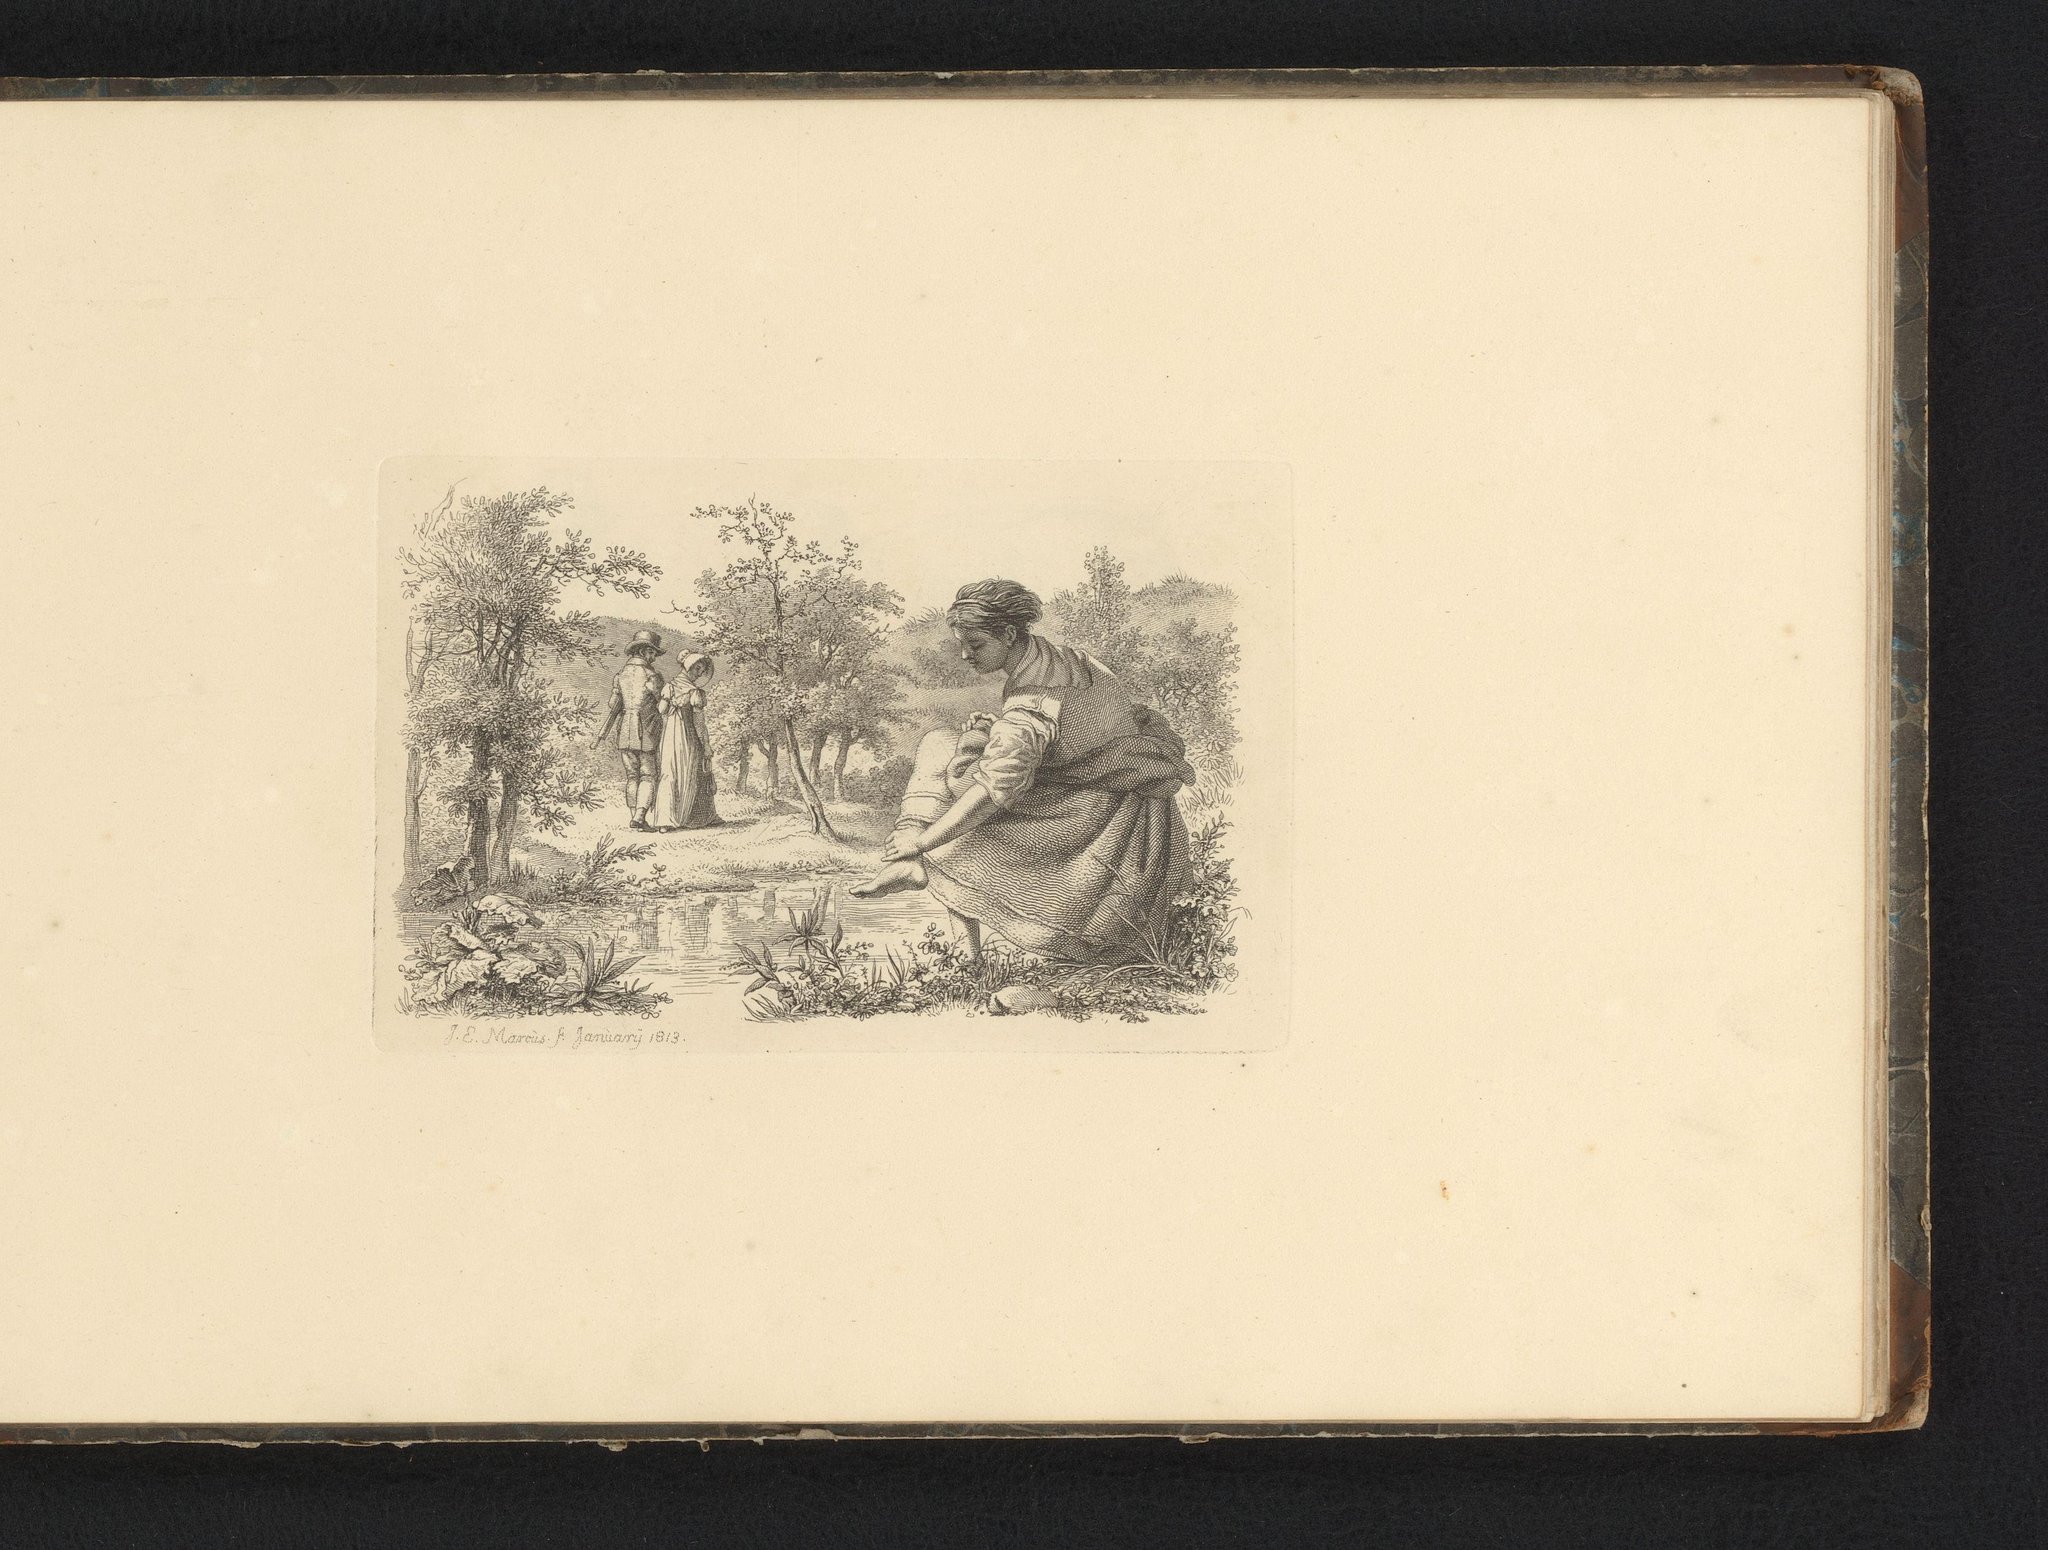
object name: print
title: Studiebeelden en fragmenten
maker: jacob ernst marcus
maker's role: draughtsman, print maker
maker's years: 1774-1826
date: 1801-1813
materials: paper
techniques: etching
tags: arm in arm (lovers), washing one's feet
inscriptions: date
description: Deze prent maakt deel uit van een album.